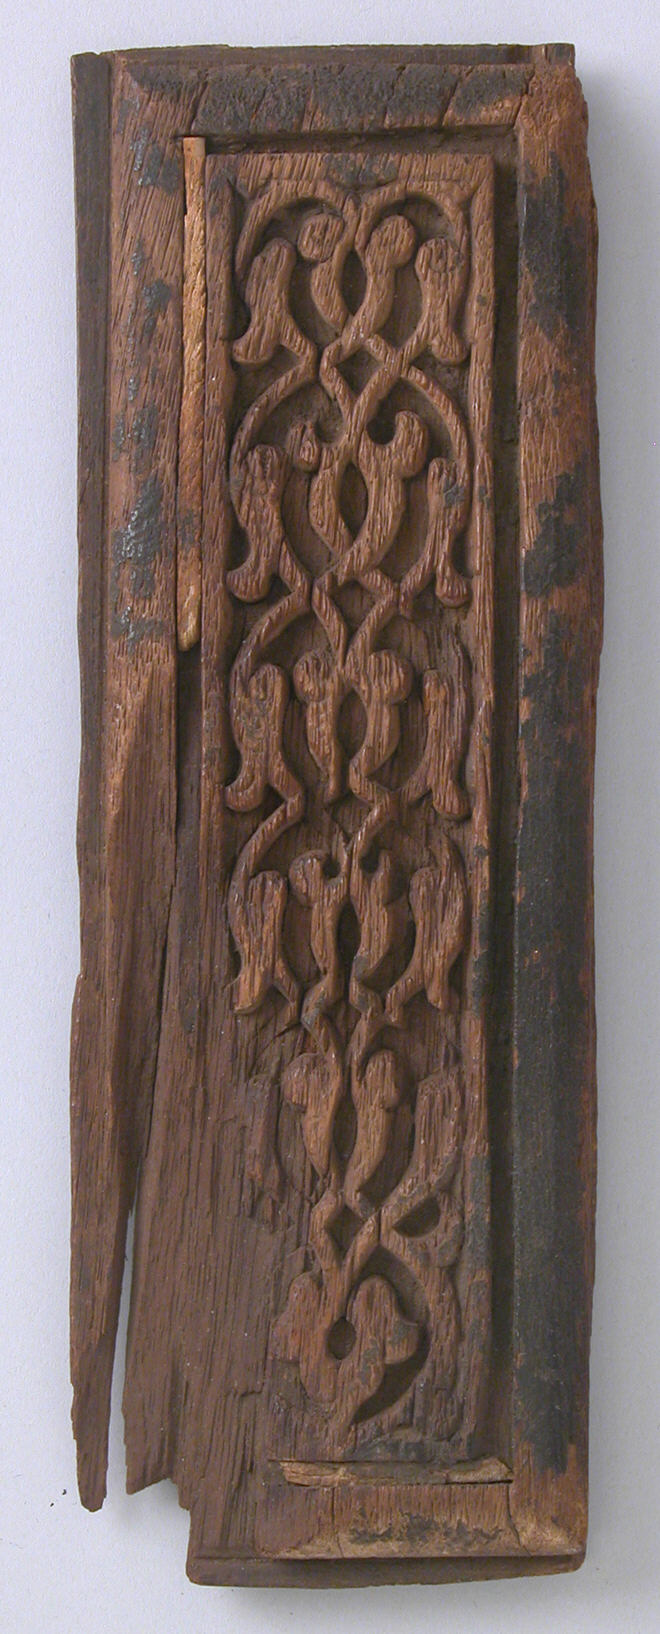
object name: panel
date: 1301-1500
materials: wood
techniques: carving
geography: egypt